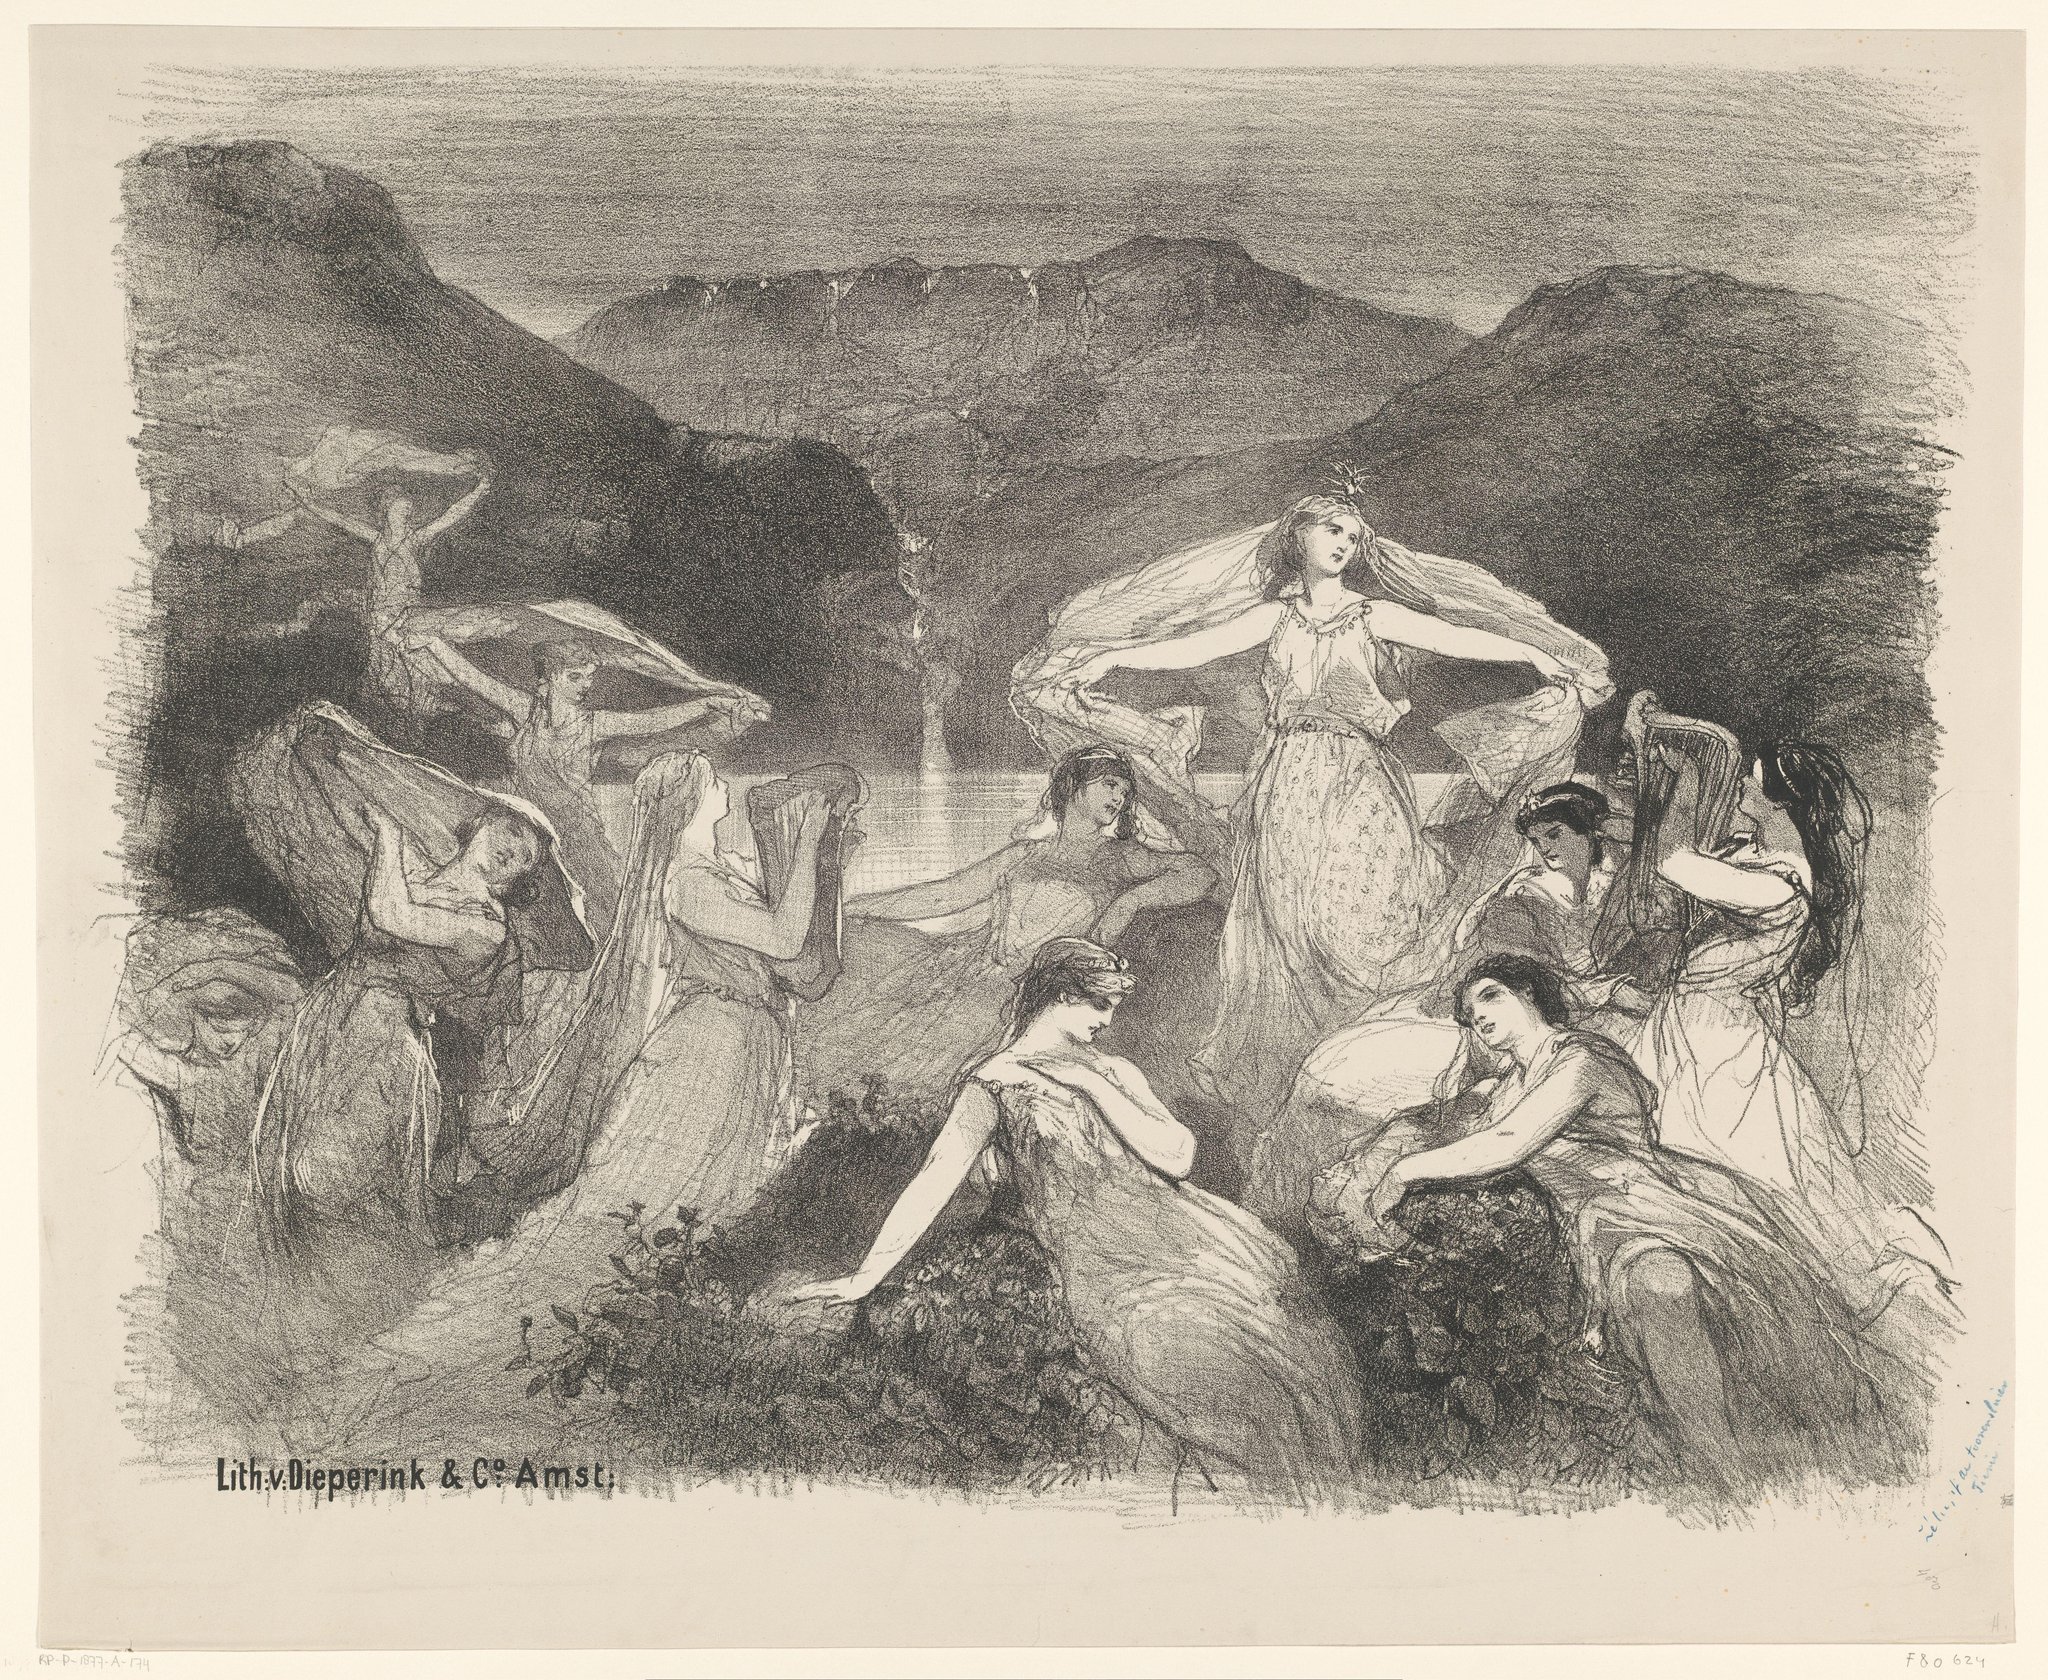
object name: print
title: Scène uit ballet Zélie of de toversluier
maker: charles rochussen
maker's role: draughtsman, painter, print maker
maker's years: 1814-1894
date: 1865-1868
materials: paper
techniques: lithograph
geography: amsterdam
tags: the ballet, ballet performance, nymphs (in general); 'ninfe in commune' (ripa)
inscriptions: inscription: ‘Zélie, of de tooversluier (...)’, collector's mark: Lugt 2228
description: Een groep nimfen zit aan de over van een meer in een berglandschap. De Koningin van de Nacht vergezelt de musicerende nimfen.